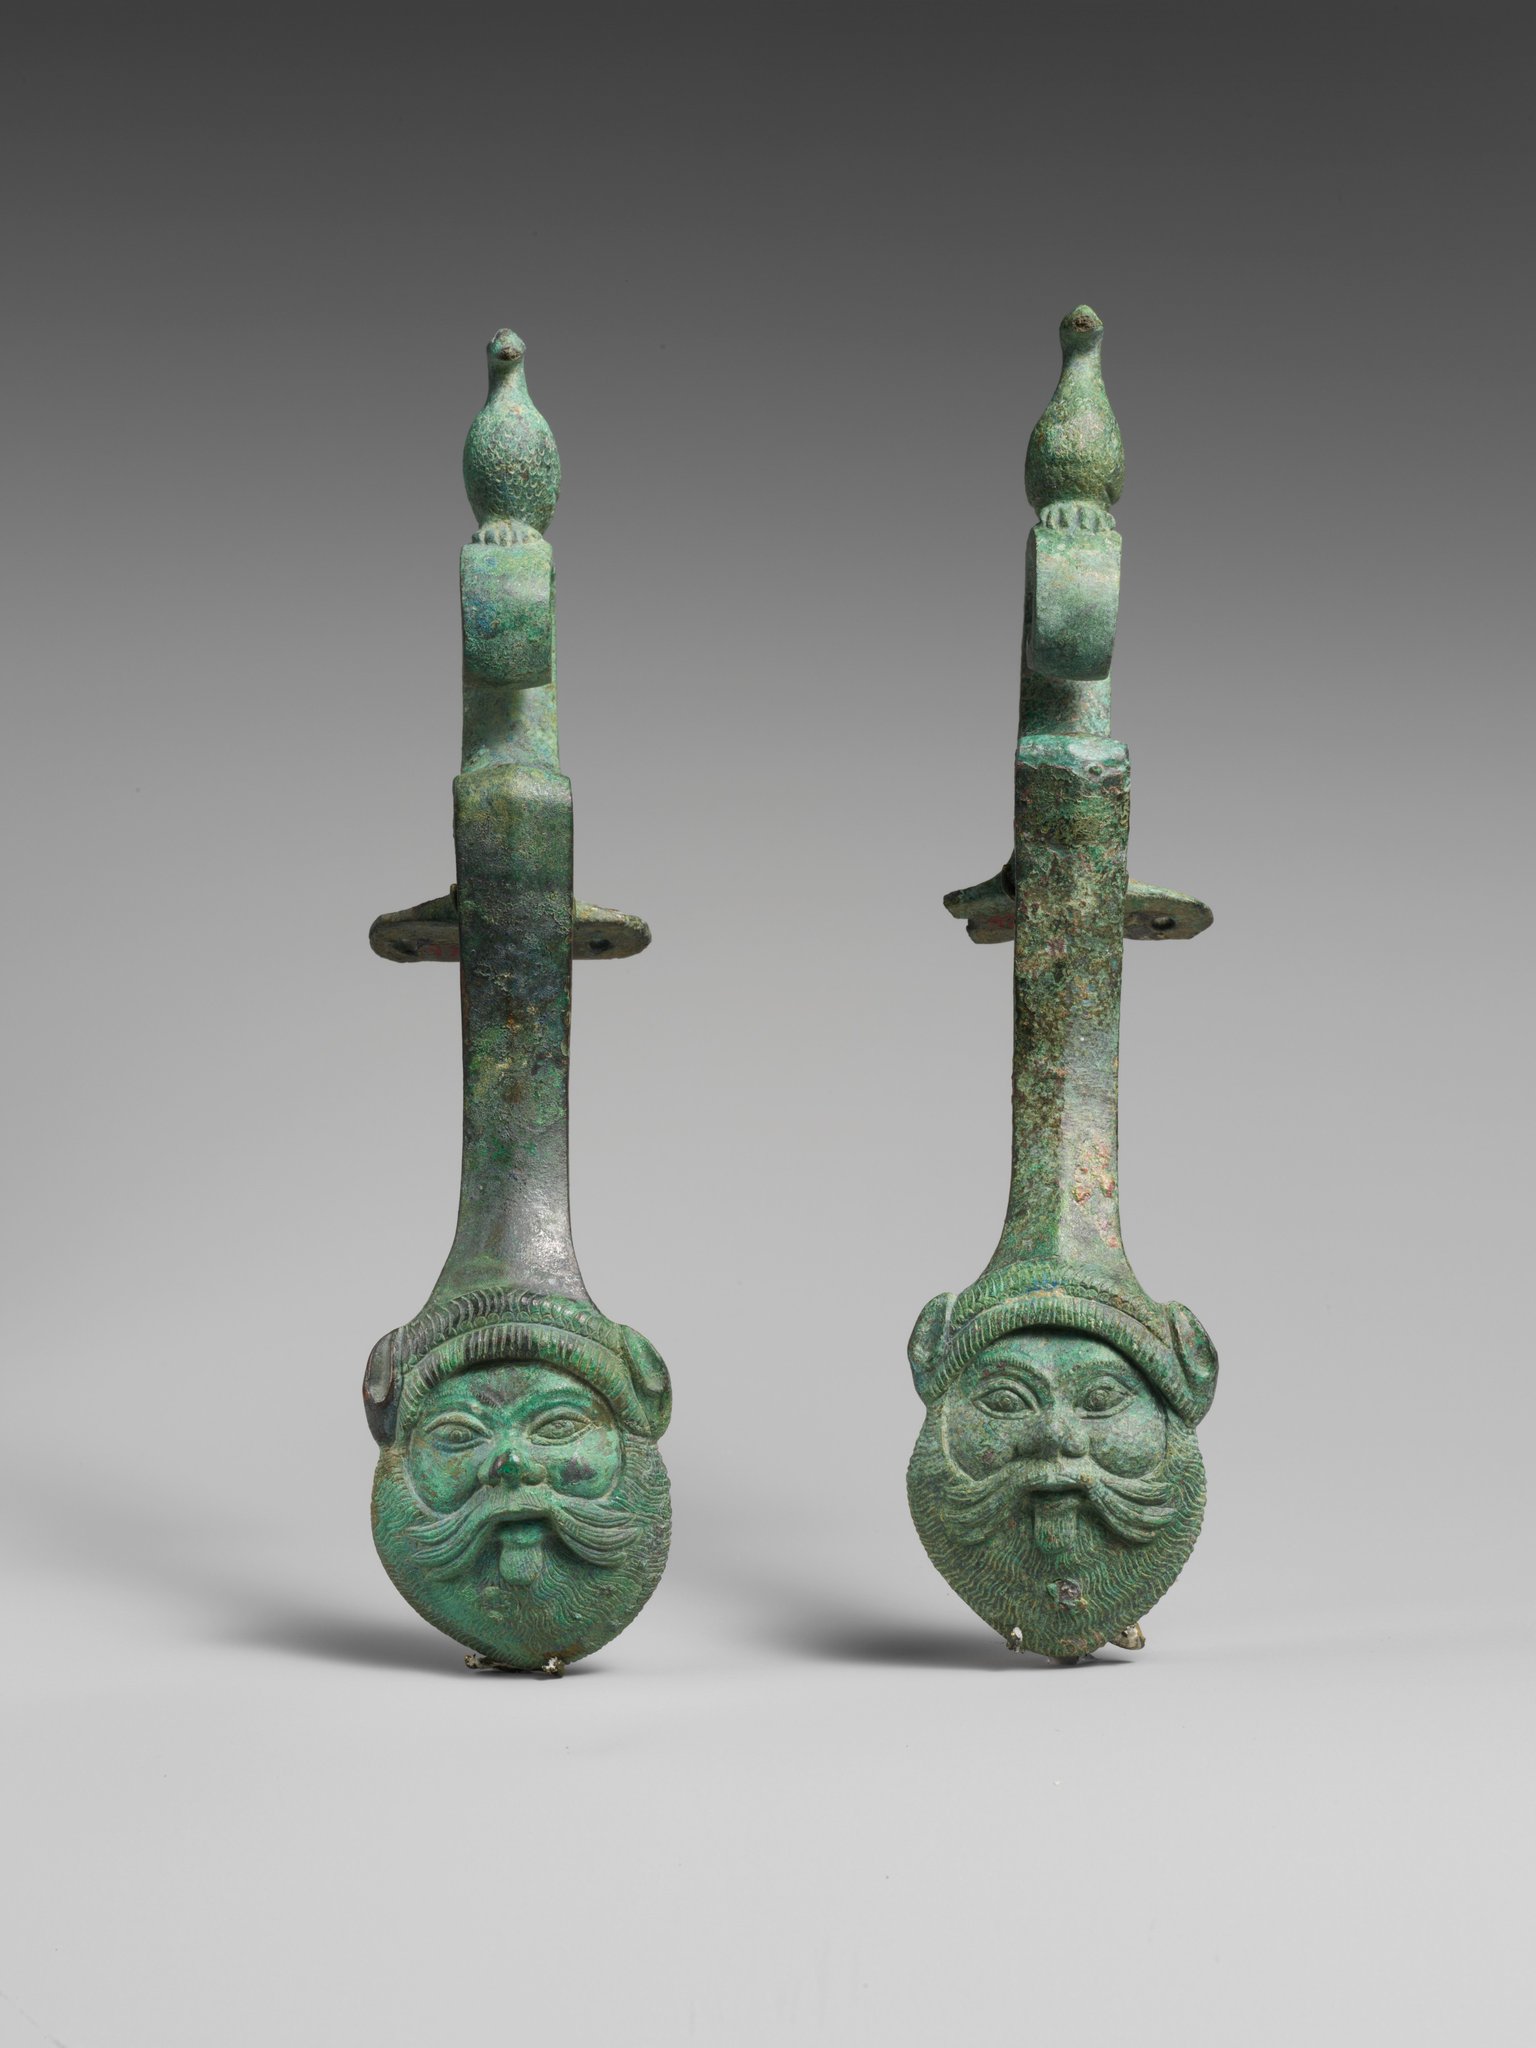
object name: handle of an amphora with silenos mask and dove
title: Pair of bronze amphora (jar) handles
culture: etruscan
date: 500-401 BCE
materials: bronze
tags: birds,faces